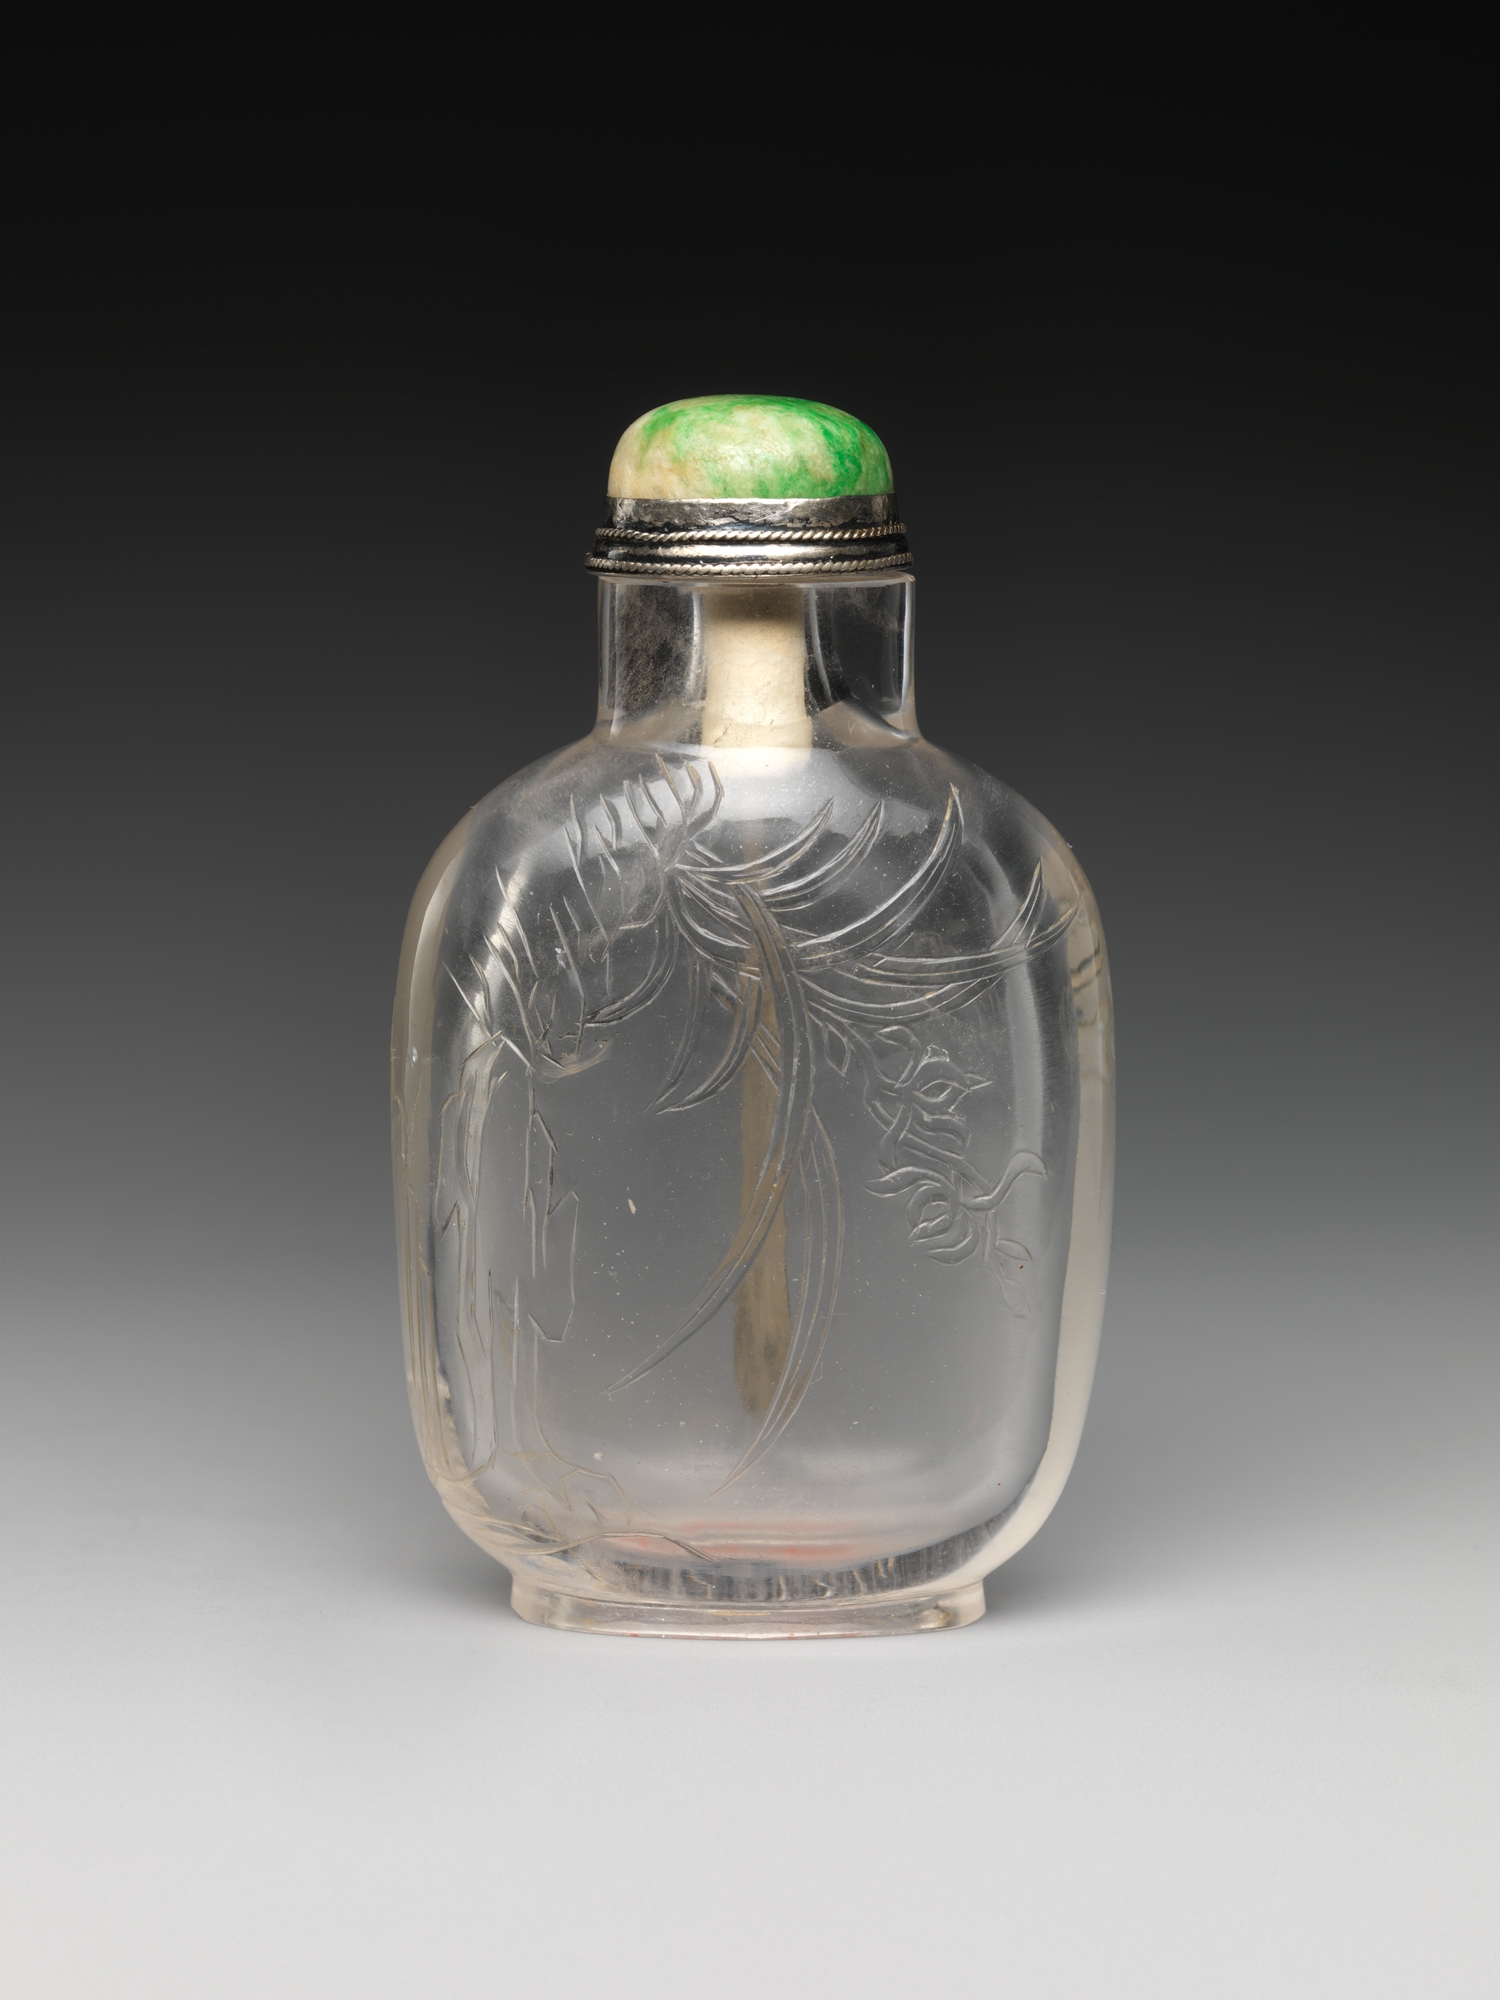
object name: snuff bottle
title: Snuff Bottle with Orchids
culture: chinese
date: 1767-1833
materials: jade, quartz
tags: orchids